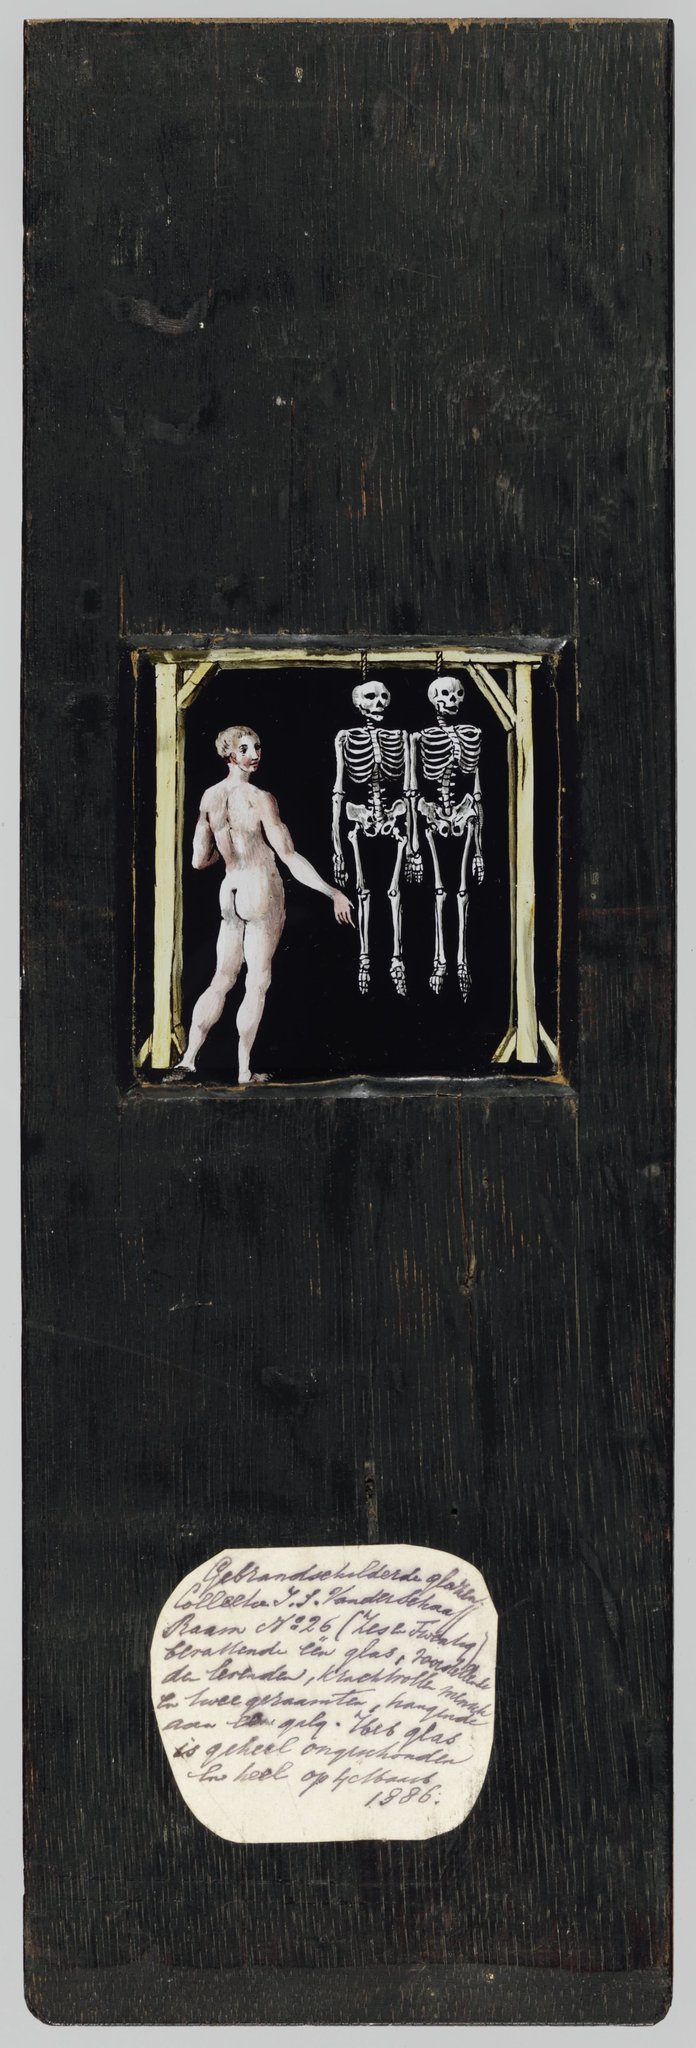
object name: lantern slide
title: Twee geraamten aan een galg en één naakte persoon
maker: Anonymous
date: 1793-1830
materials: glass, wood, oil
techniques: painted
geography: france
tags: violent death by hanging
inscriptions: label: ‘'Gebrandschilderde glazen. Collectie J. I. Van der Schaaff Baarn. Nr. 26 (zes en twintig) bevattende één glas, voorstellende den levenden, krachtvolle mensch en twee geraamten, hangende aan een galg. Het glas is geheel ongeschonden en heel op 4 maart 1886.'’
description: Vierkante glasplaat in houten vatting. Twee geraamten hangen aan een galg. Daarnaast een naakte persoon, van de rug gezien, die naar de twee geraamtes gebaart. De achtergrond is zwart.